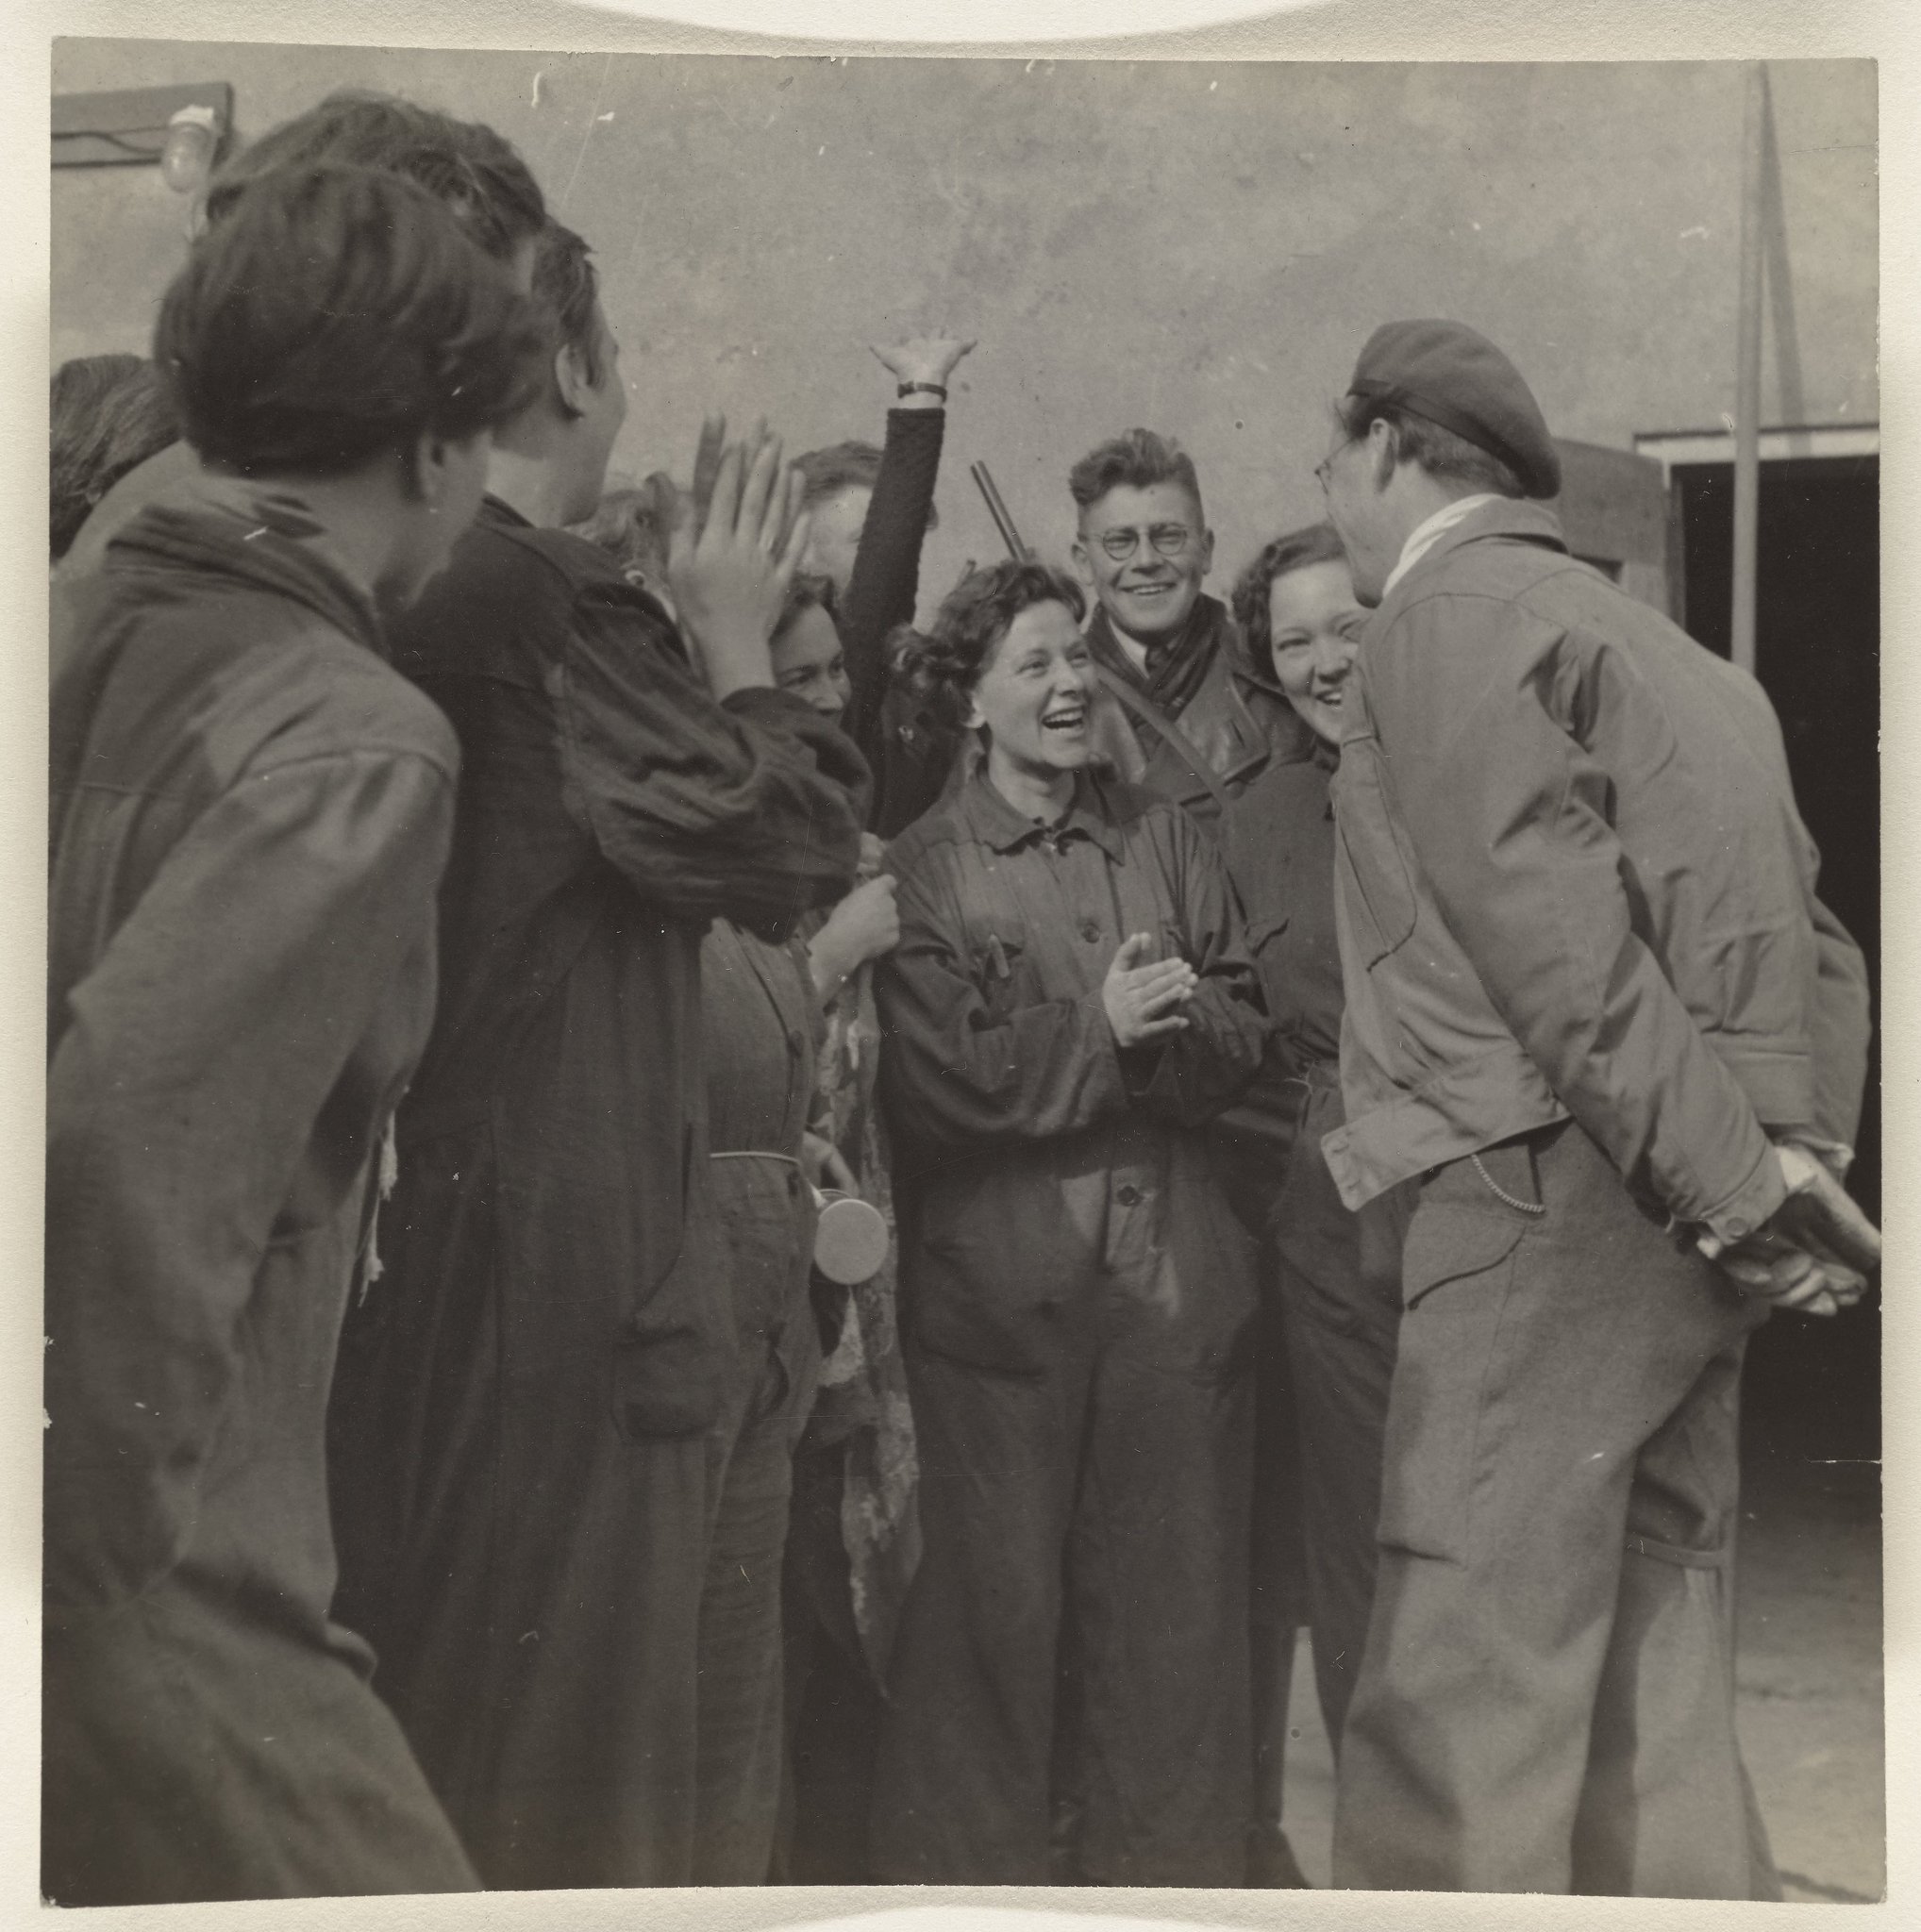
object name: photograph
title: Prins Bernhard op rondreis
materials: photographic support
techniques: photography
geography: netherlands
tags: utrecht, bernhard (prins der nederlanden), netherlands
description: Prins Bernhard tijdens zijn rondreis langs verschillende steden in Noord-Osst Nederland temidden van mannen en vrouwen in overalls.